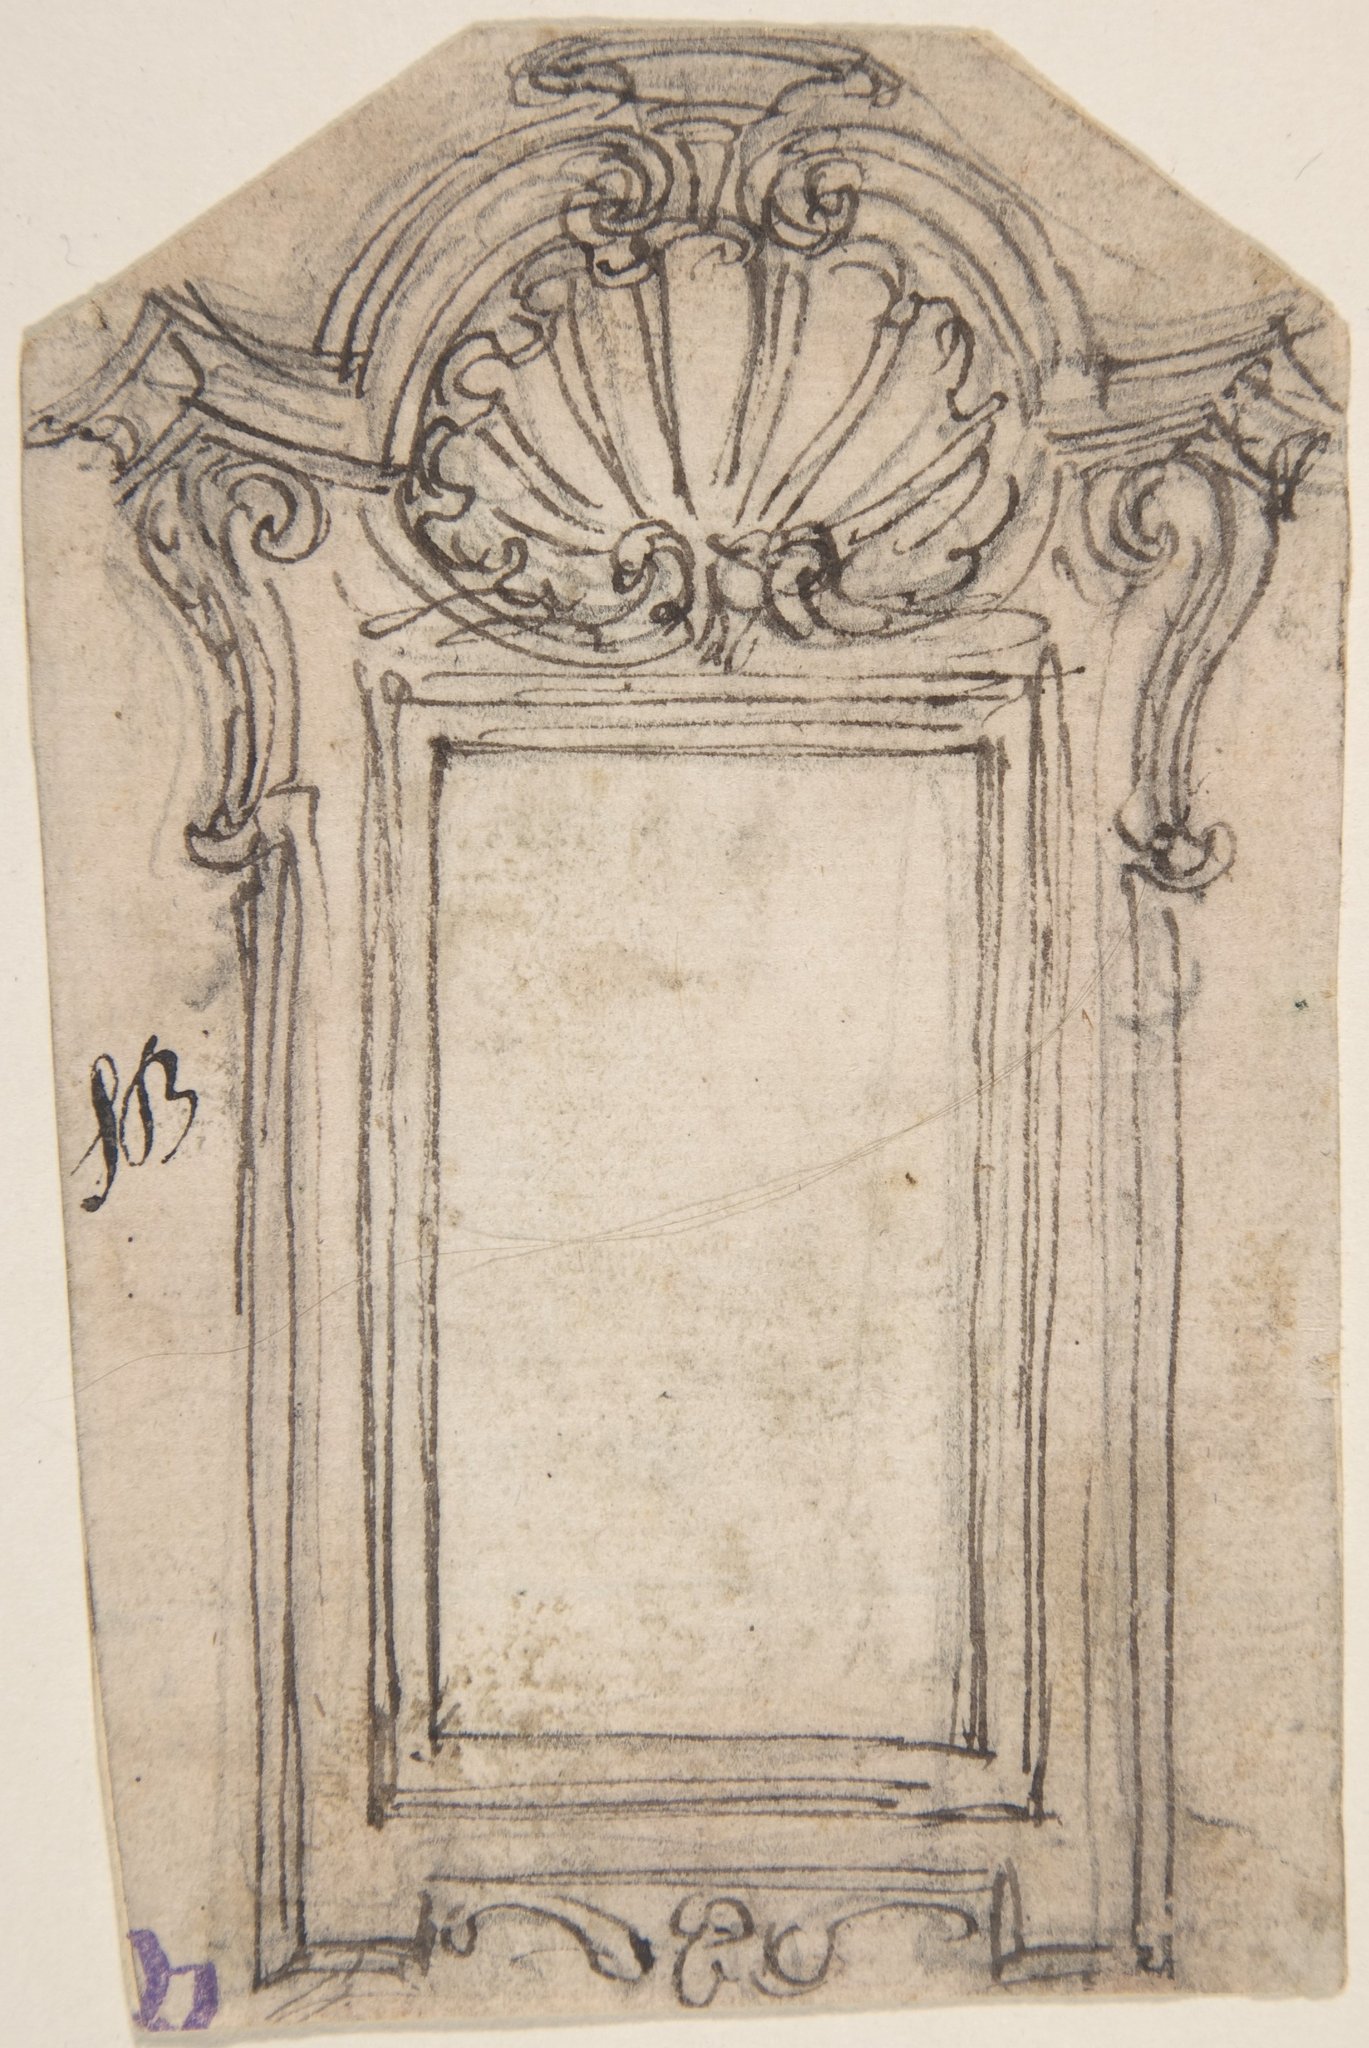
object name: drawing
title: Design for a Frame Decorated with a Shell Motif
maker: giovanni battista foggini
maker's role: artist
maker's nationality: italian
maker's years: 1652-1725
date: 1672-1725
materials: chalk, ink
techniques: pen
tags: ornament